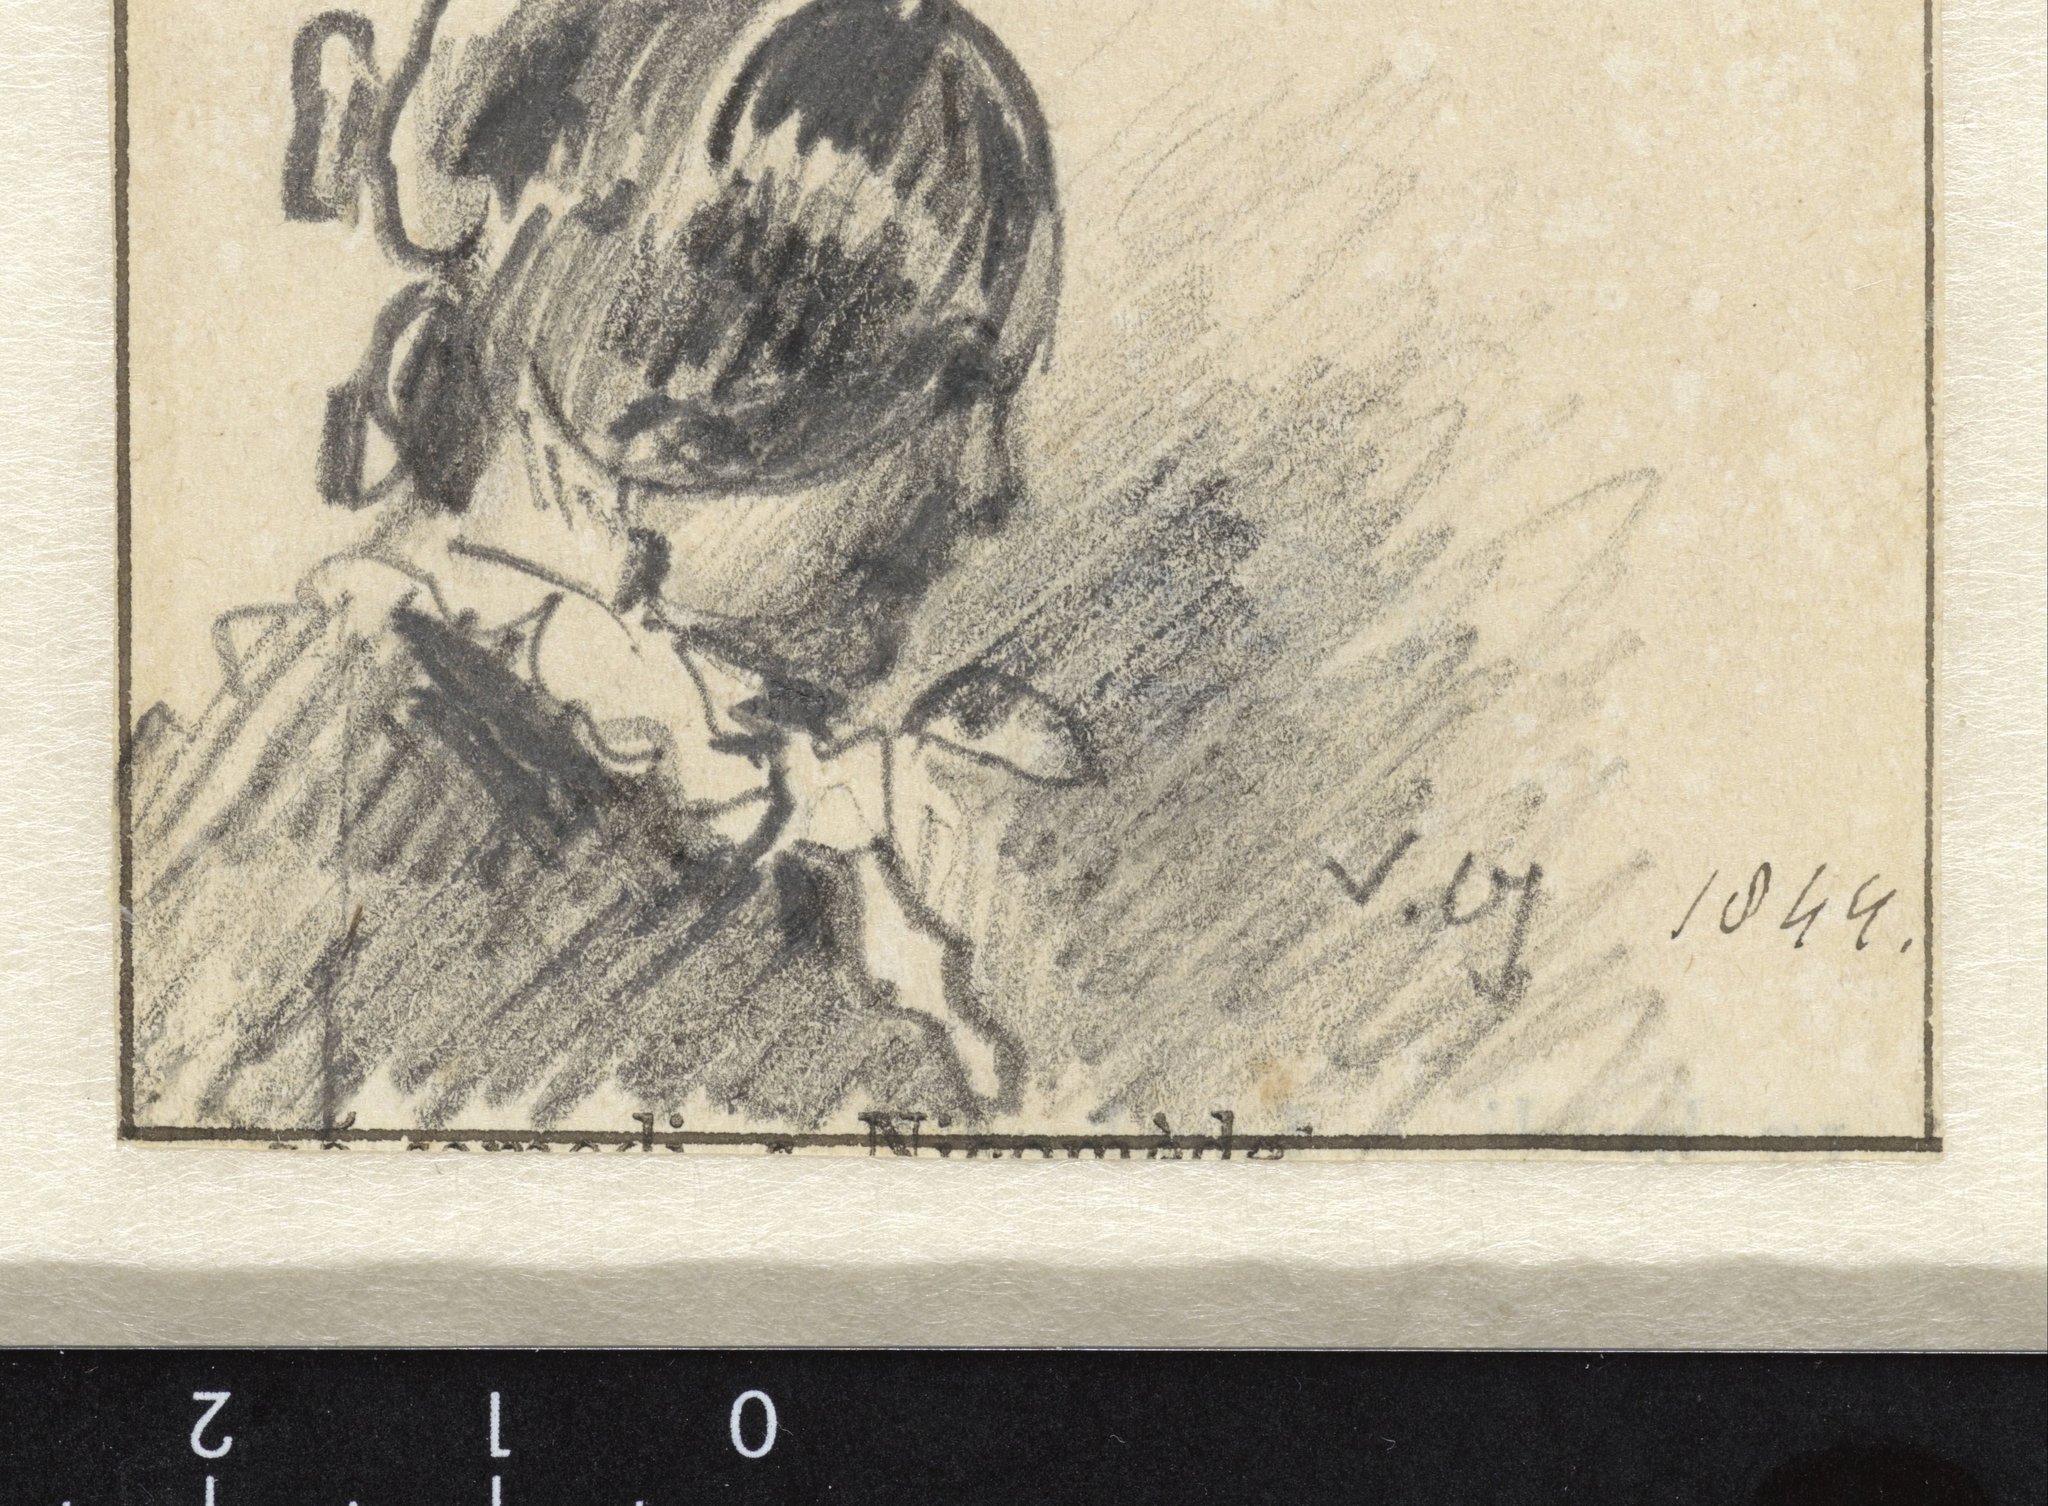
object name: drawing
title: Schets van een vrouwenhoofd, in profiel naar rechts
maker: georgius jacobus johannes van os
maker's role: draughtsman, painter, print maker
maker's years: 1782-1861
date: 1844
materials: paper, pencil